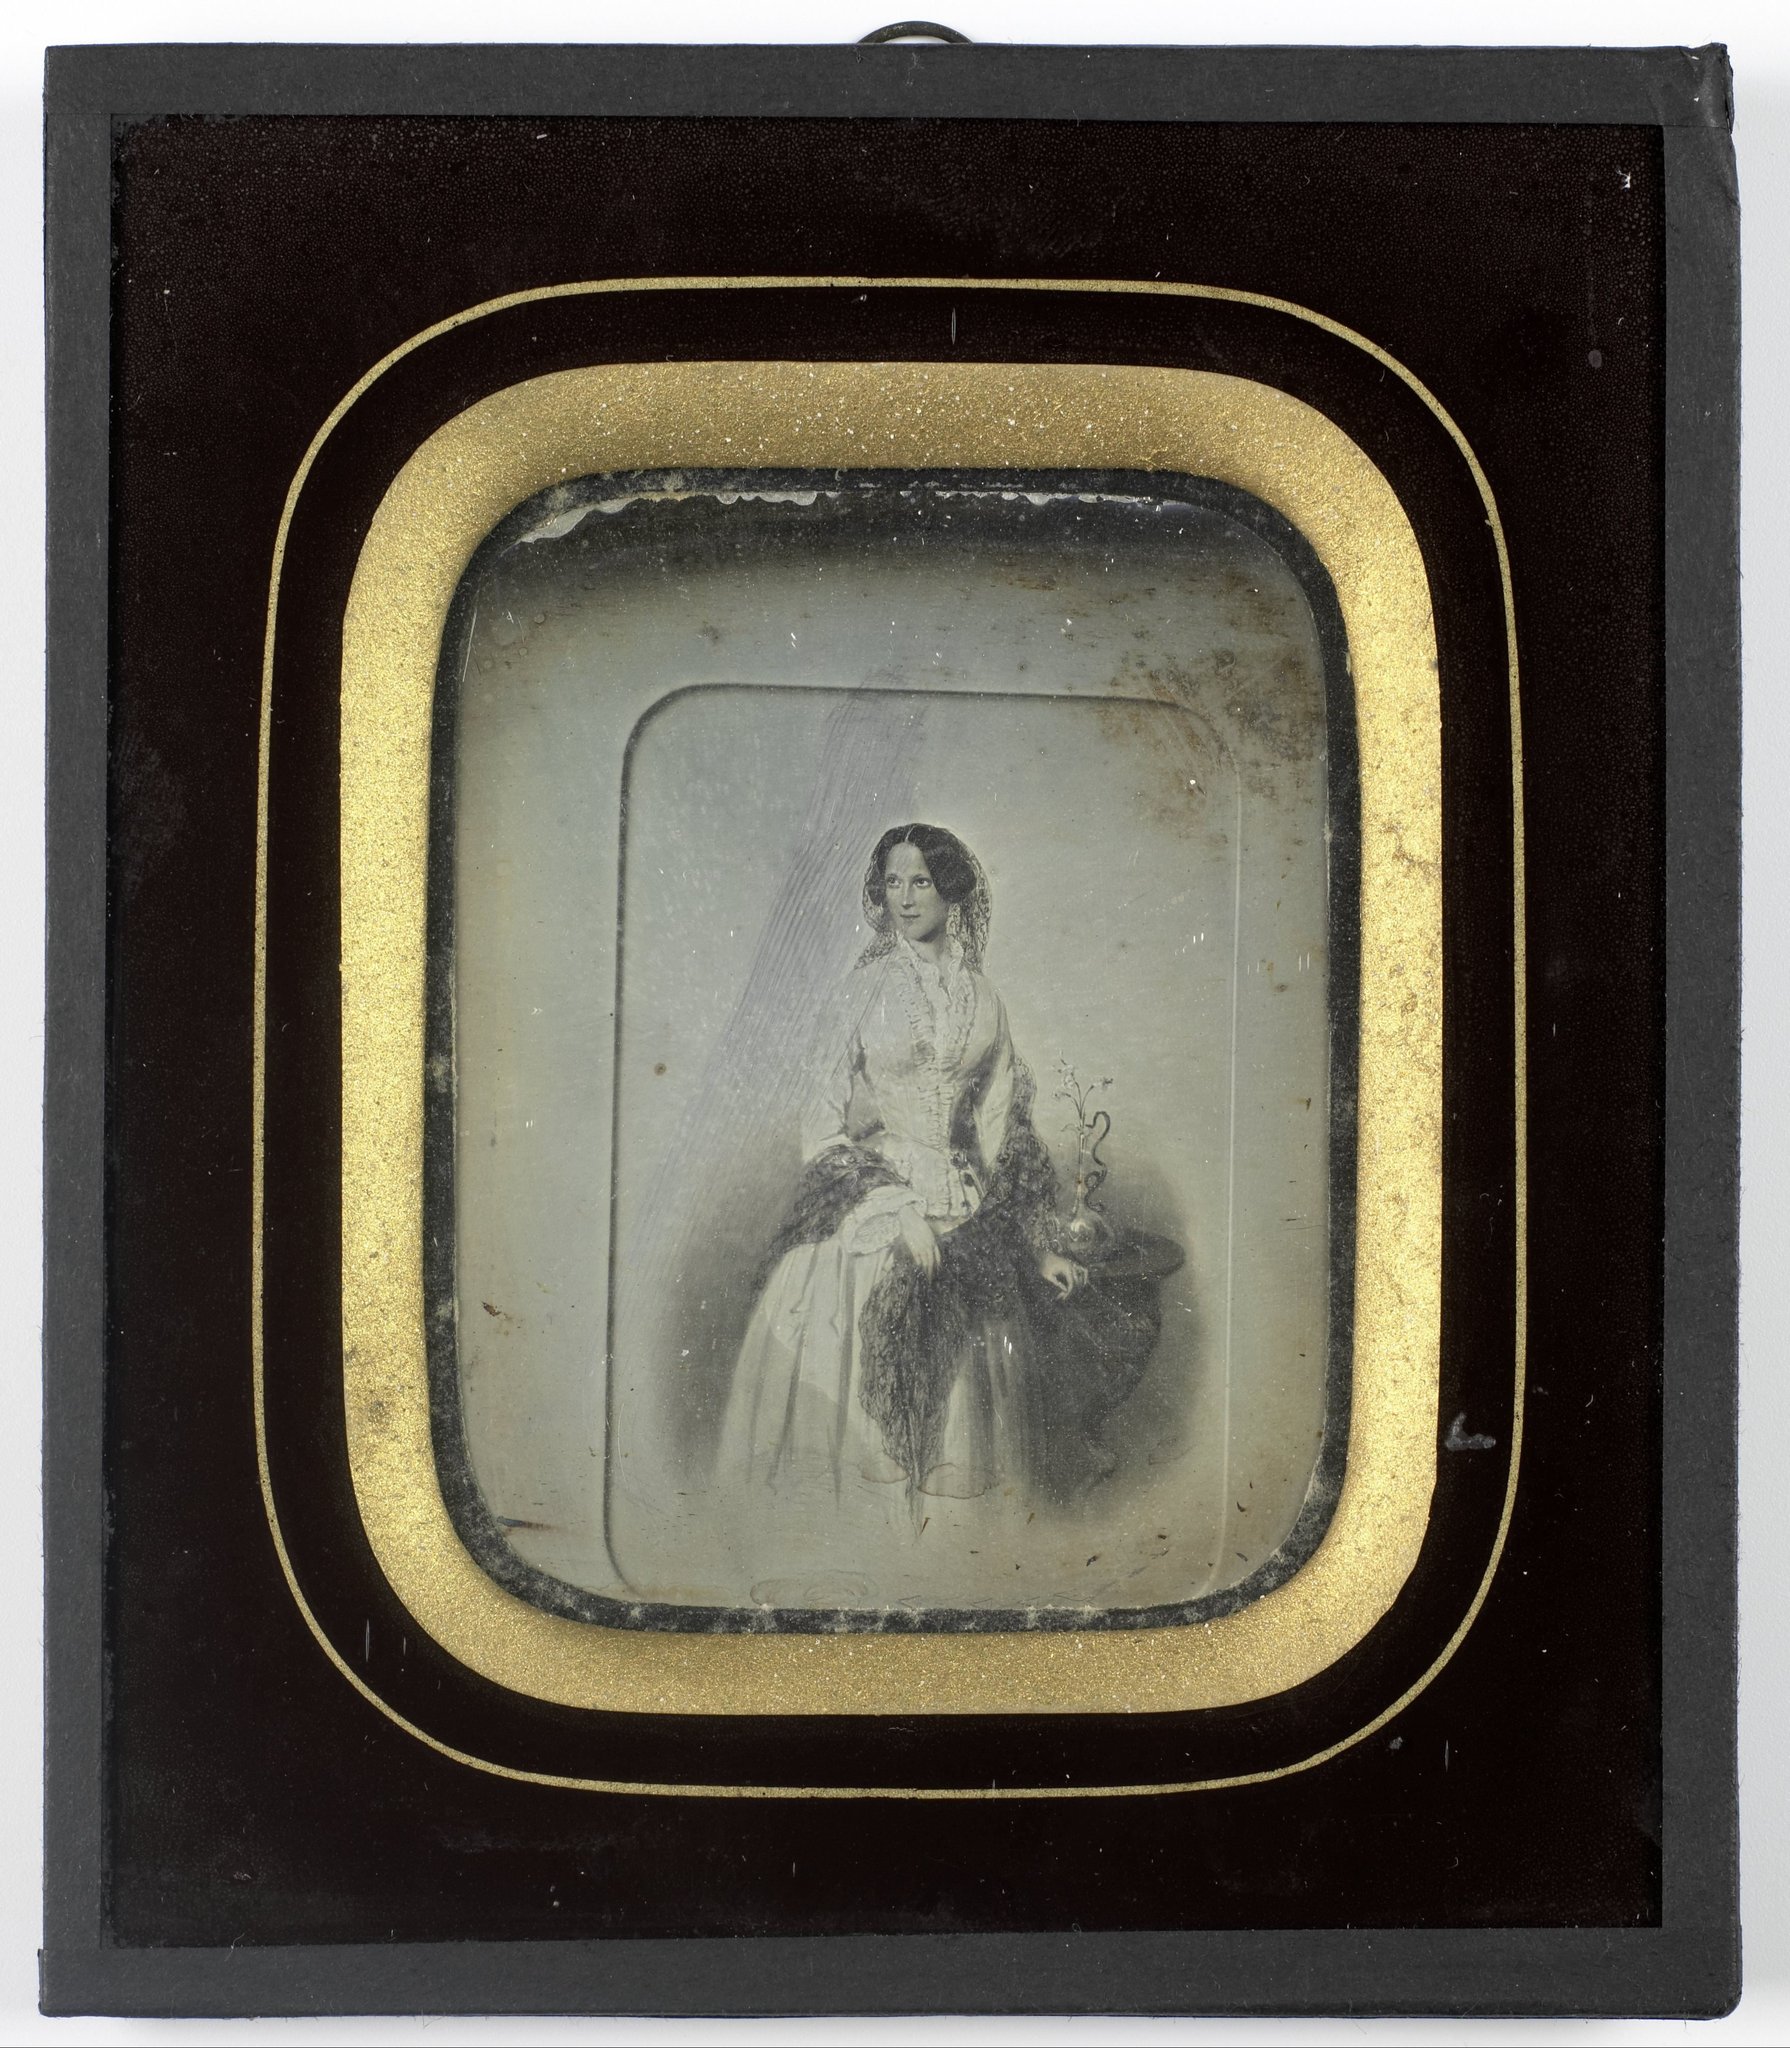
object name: photograph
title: Portret van een onbekende vrouw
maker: Anonymous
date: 1840-1860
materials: copper, glass, paper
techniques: daguerreotype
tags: adult woman, historical persons